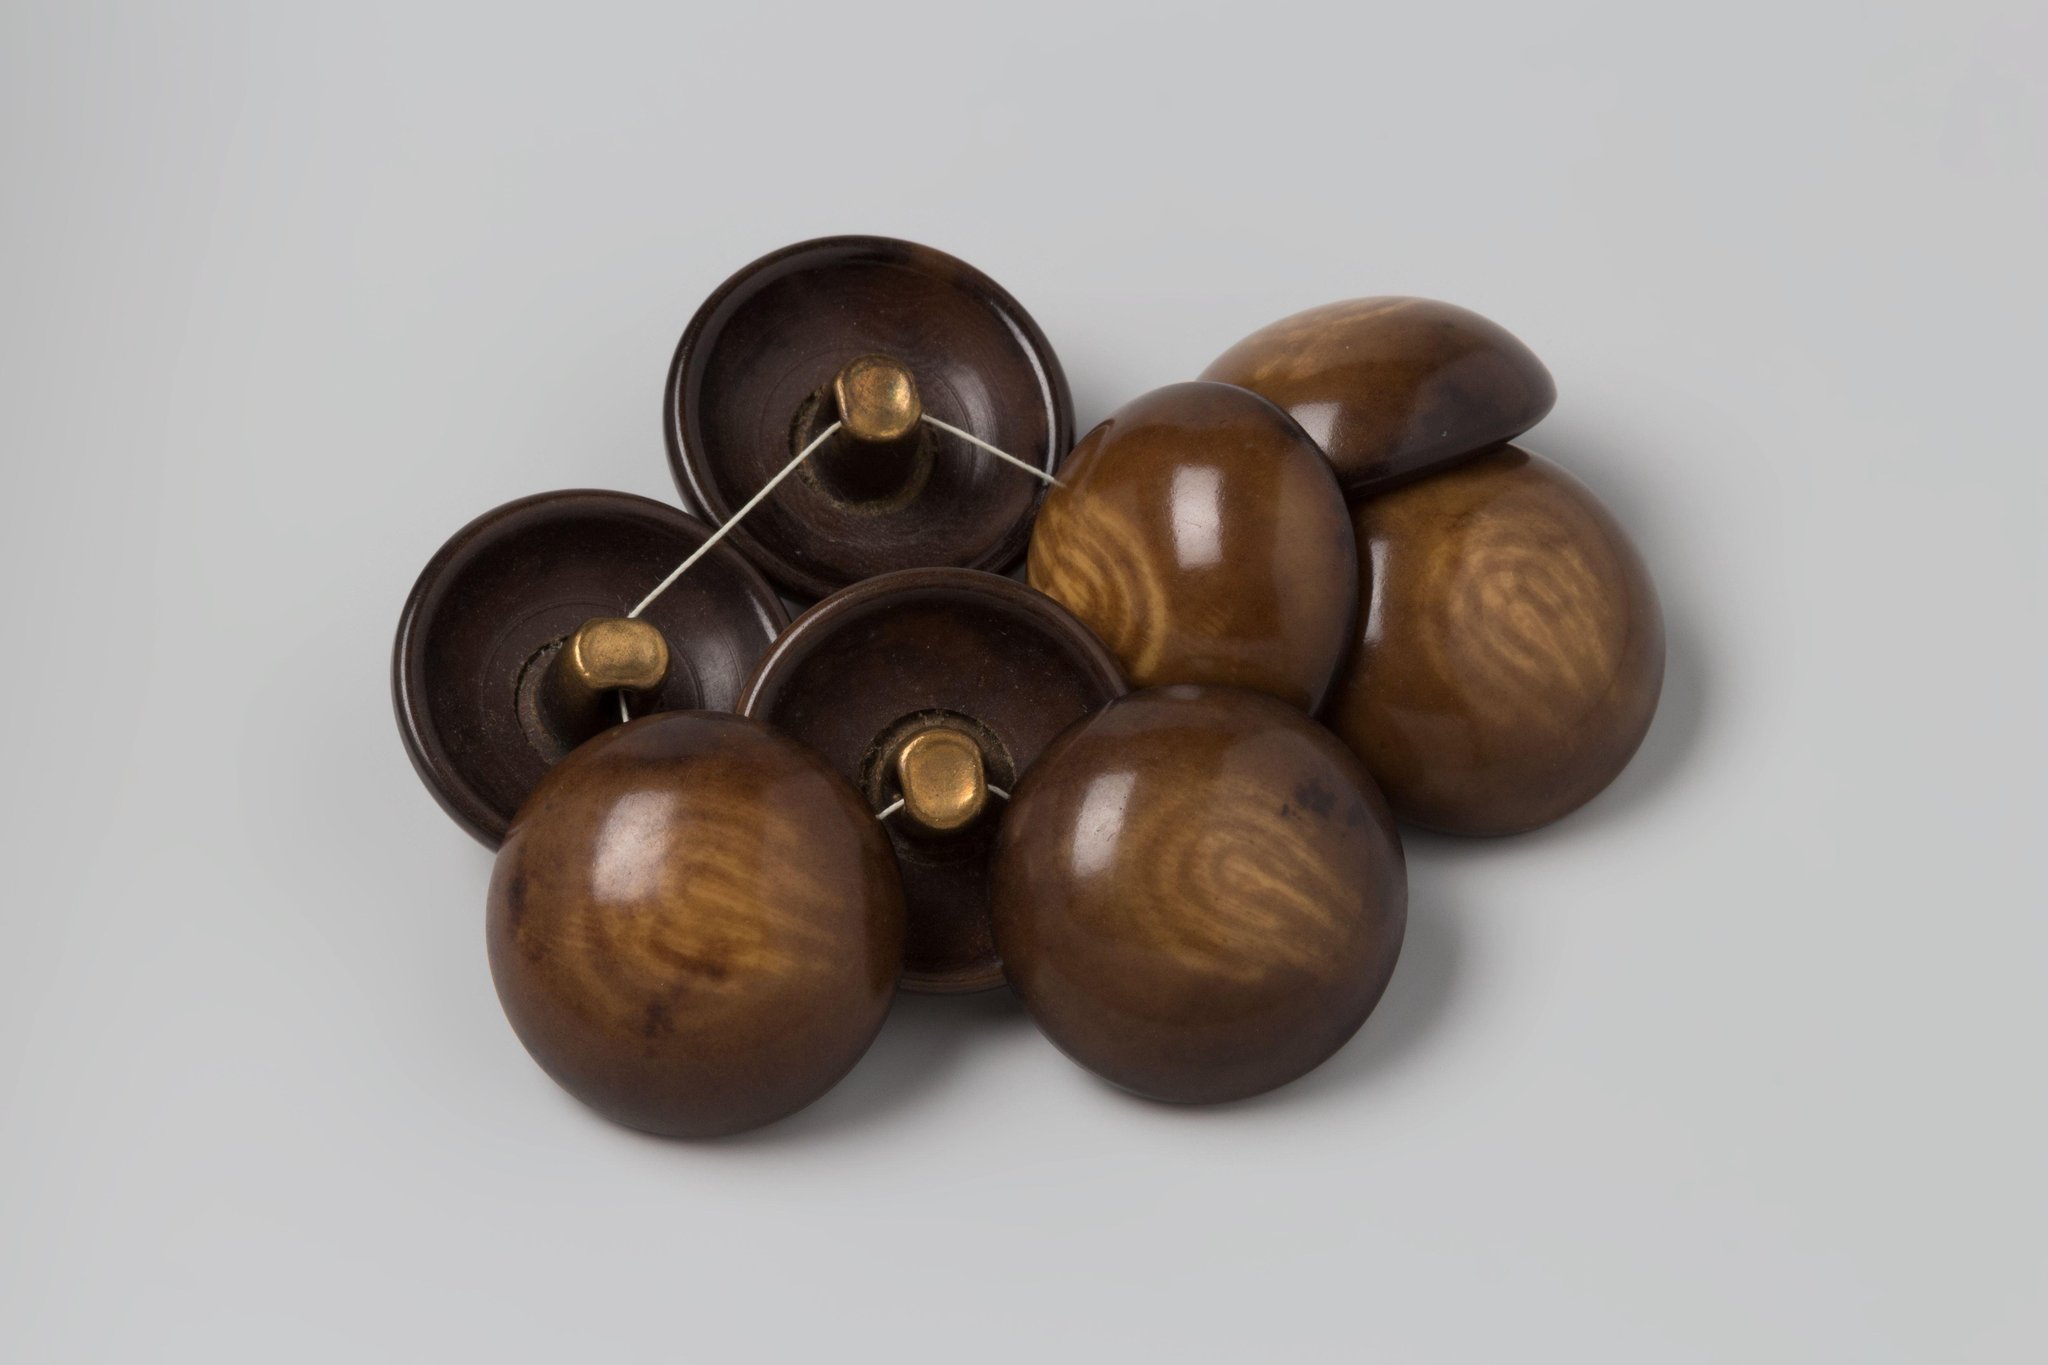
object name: button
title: Knoop (8 stuks), bol, van bruin en beige kunststof (celluloid?) met koperen oog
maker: Anonymous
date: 1905-1915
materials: celluloid, copper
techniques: casting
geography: netherlands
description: Acht grote bolle knopen van bruin en beige kunststof (celluloid). Nederland, ca. 1910(?)